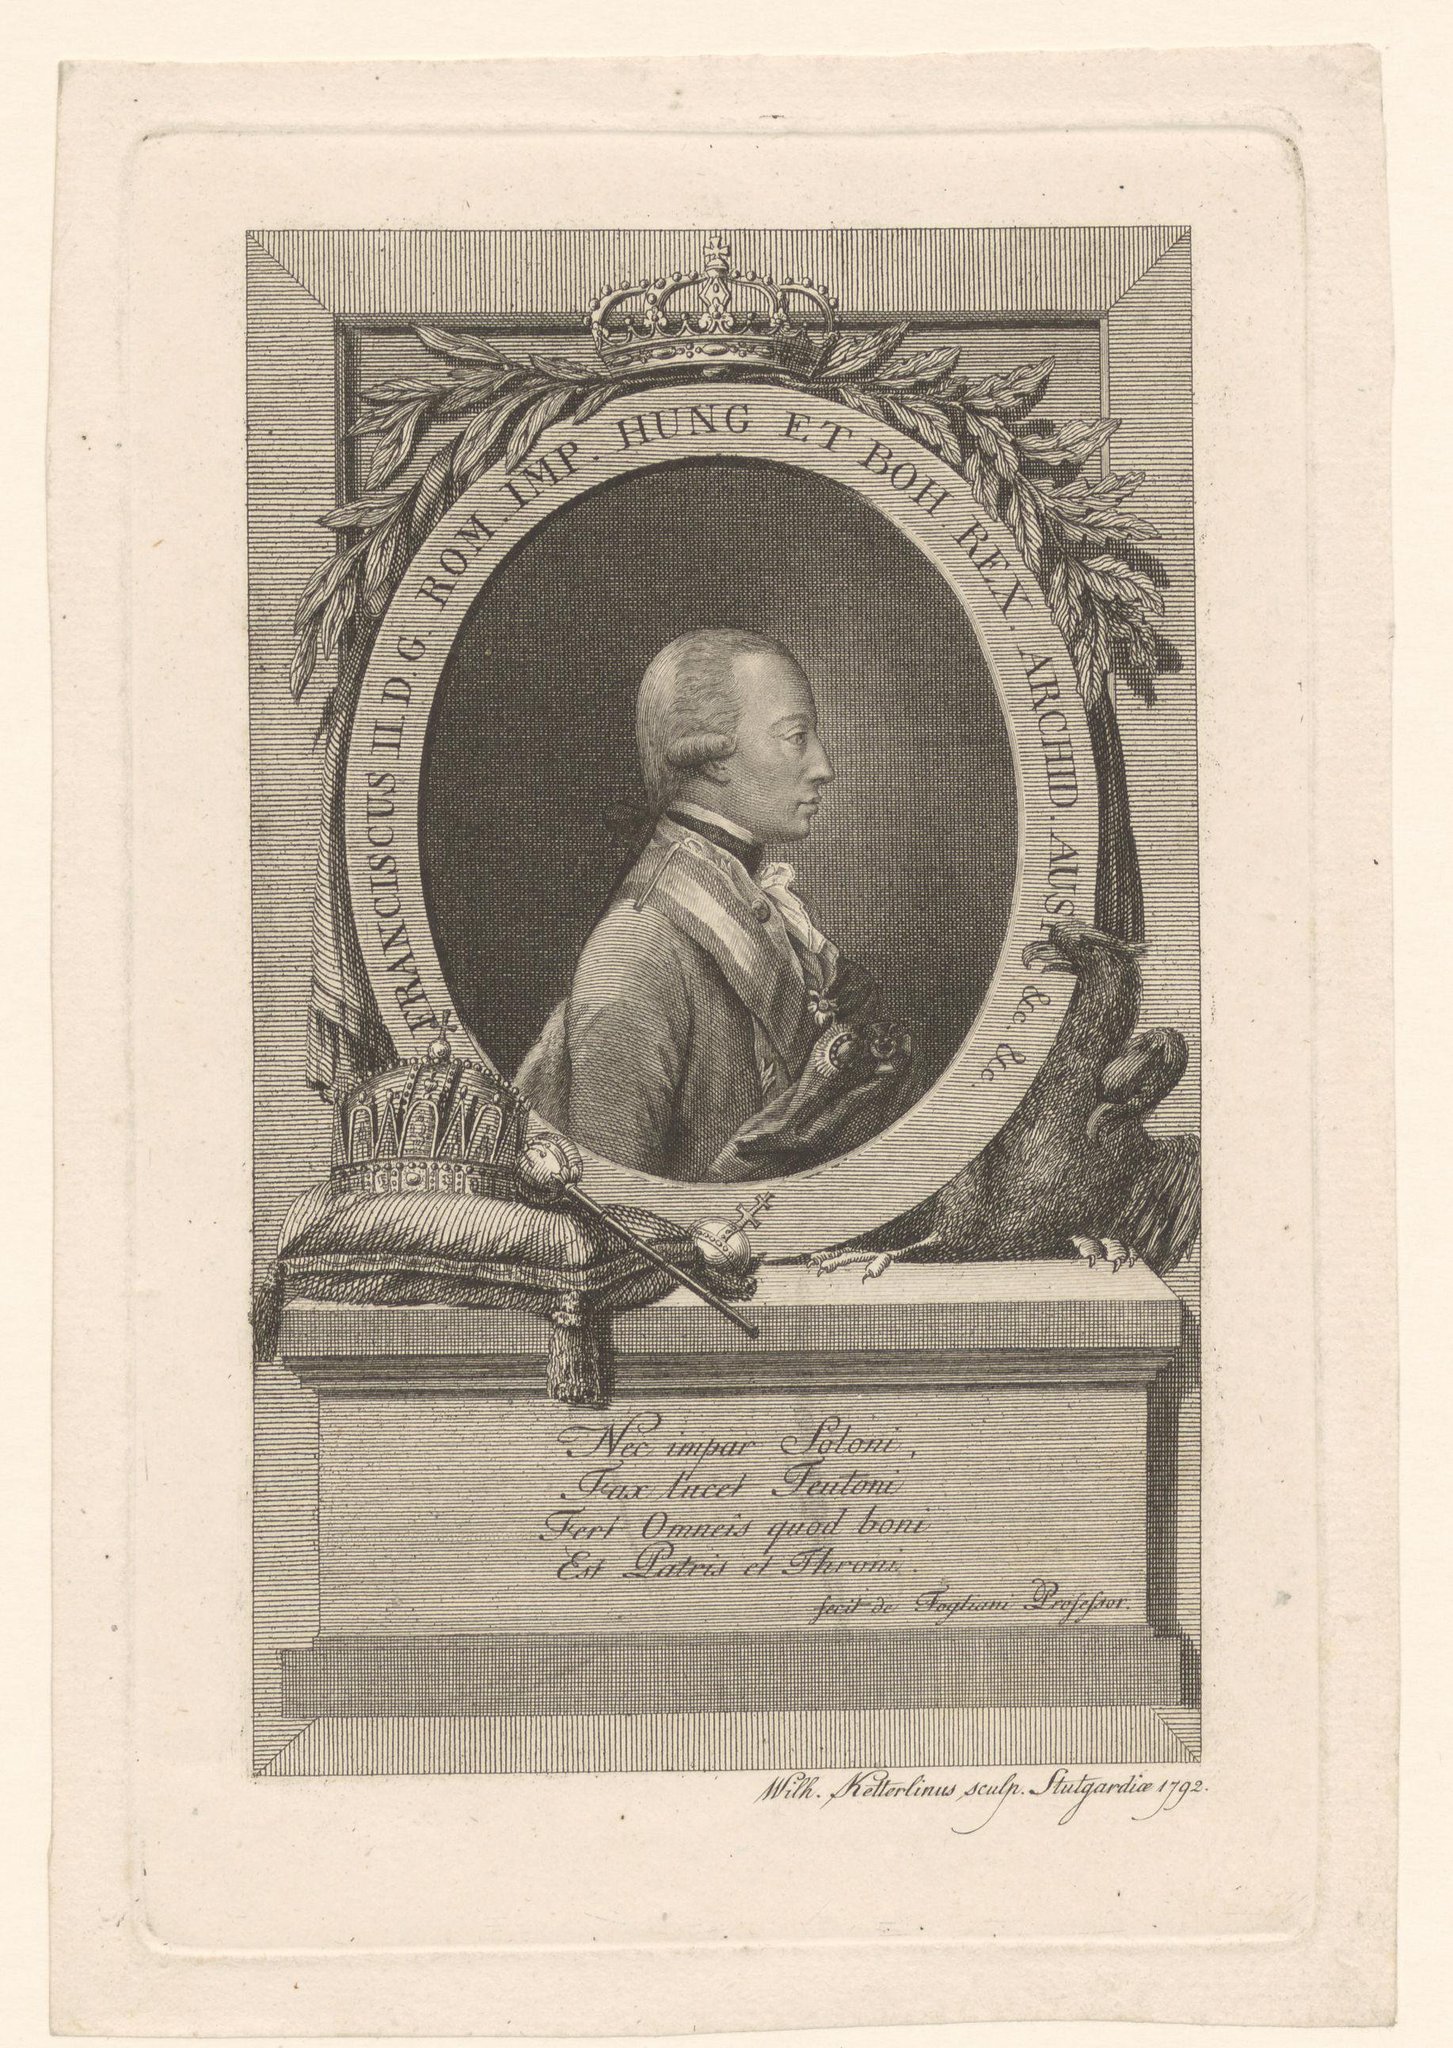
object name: print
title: Portret van Frans II Josef Karel, Rooms-Duits keizer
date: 1792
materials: paper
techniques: engraving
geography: stuttgart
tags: vienna, frans ii (rooms-duits keizer), historical persons, ruler, sovereign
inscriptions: collector's mark: Lugt 2233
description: Tekst in het Latijn op de sokkel onderaan.